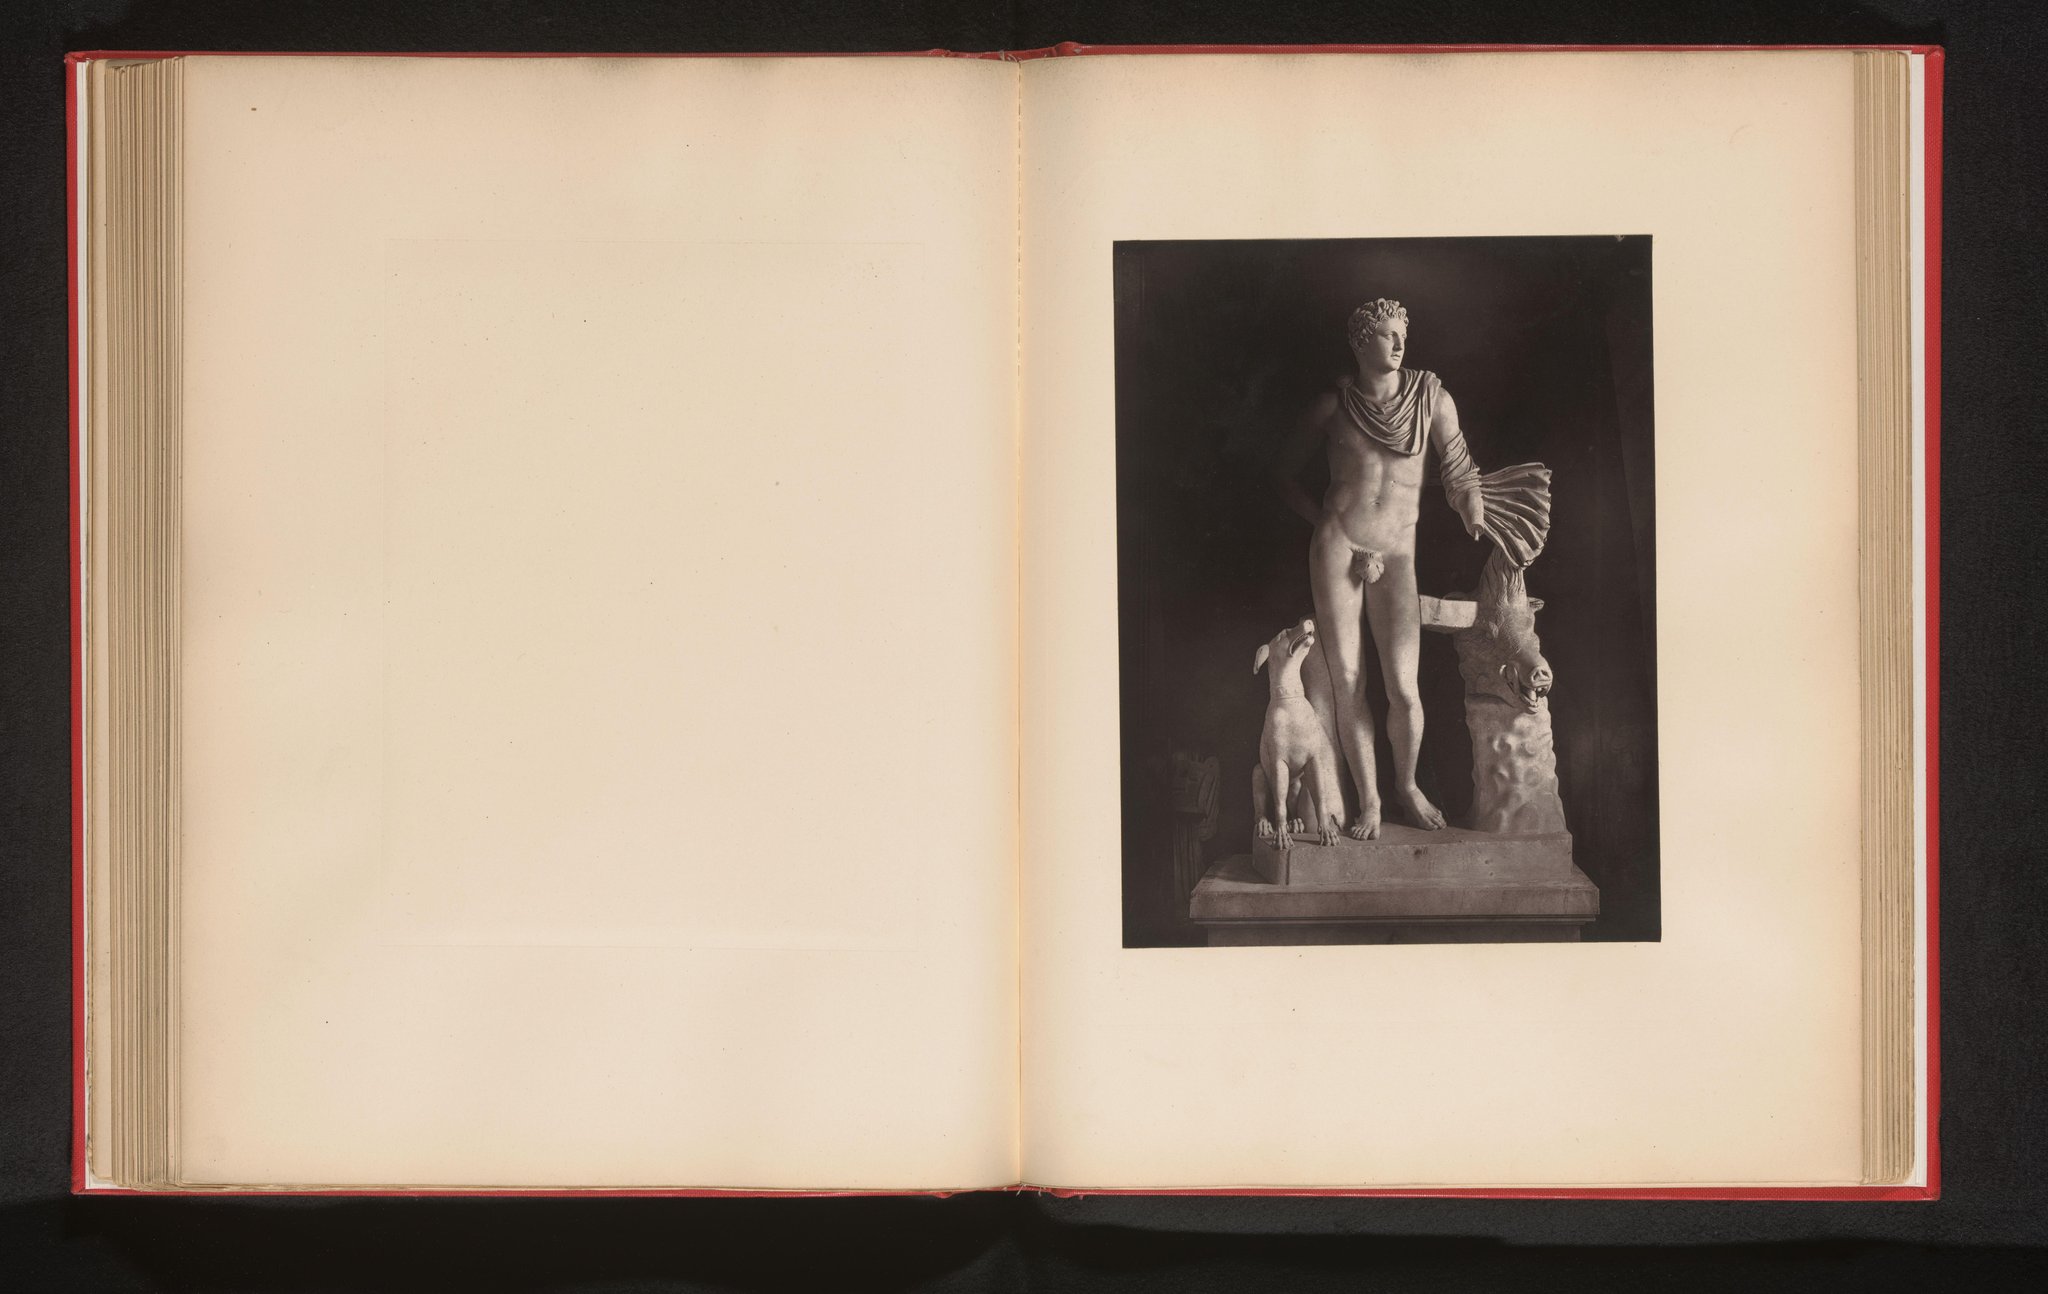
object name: photomechanical print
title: Standbeeld van Meleager door Skopas van Paros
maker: stephen thompson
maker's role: fotograaf, schrijver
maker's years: 1831-1893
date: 1873-1878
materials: paper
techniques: woodburytype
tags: sculpture, (story of) meleager